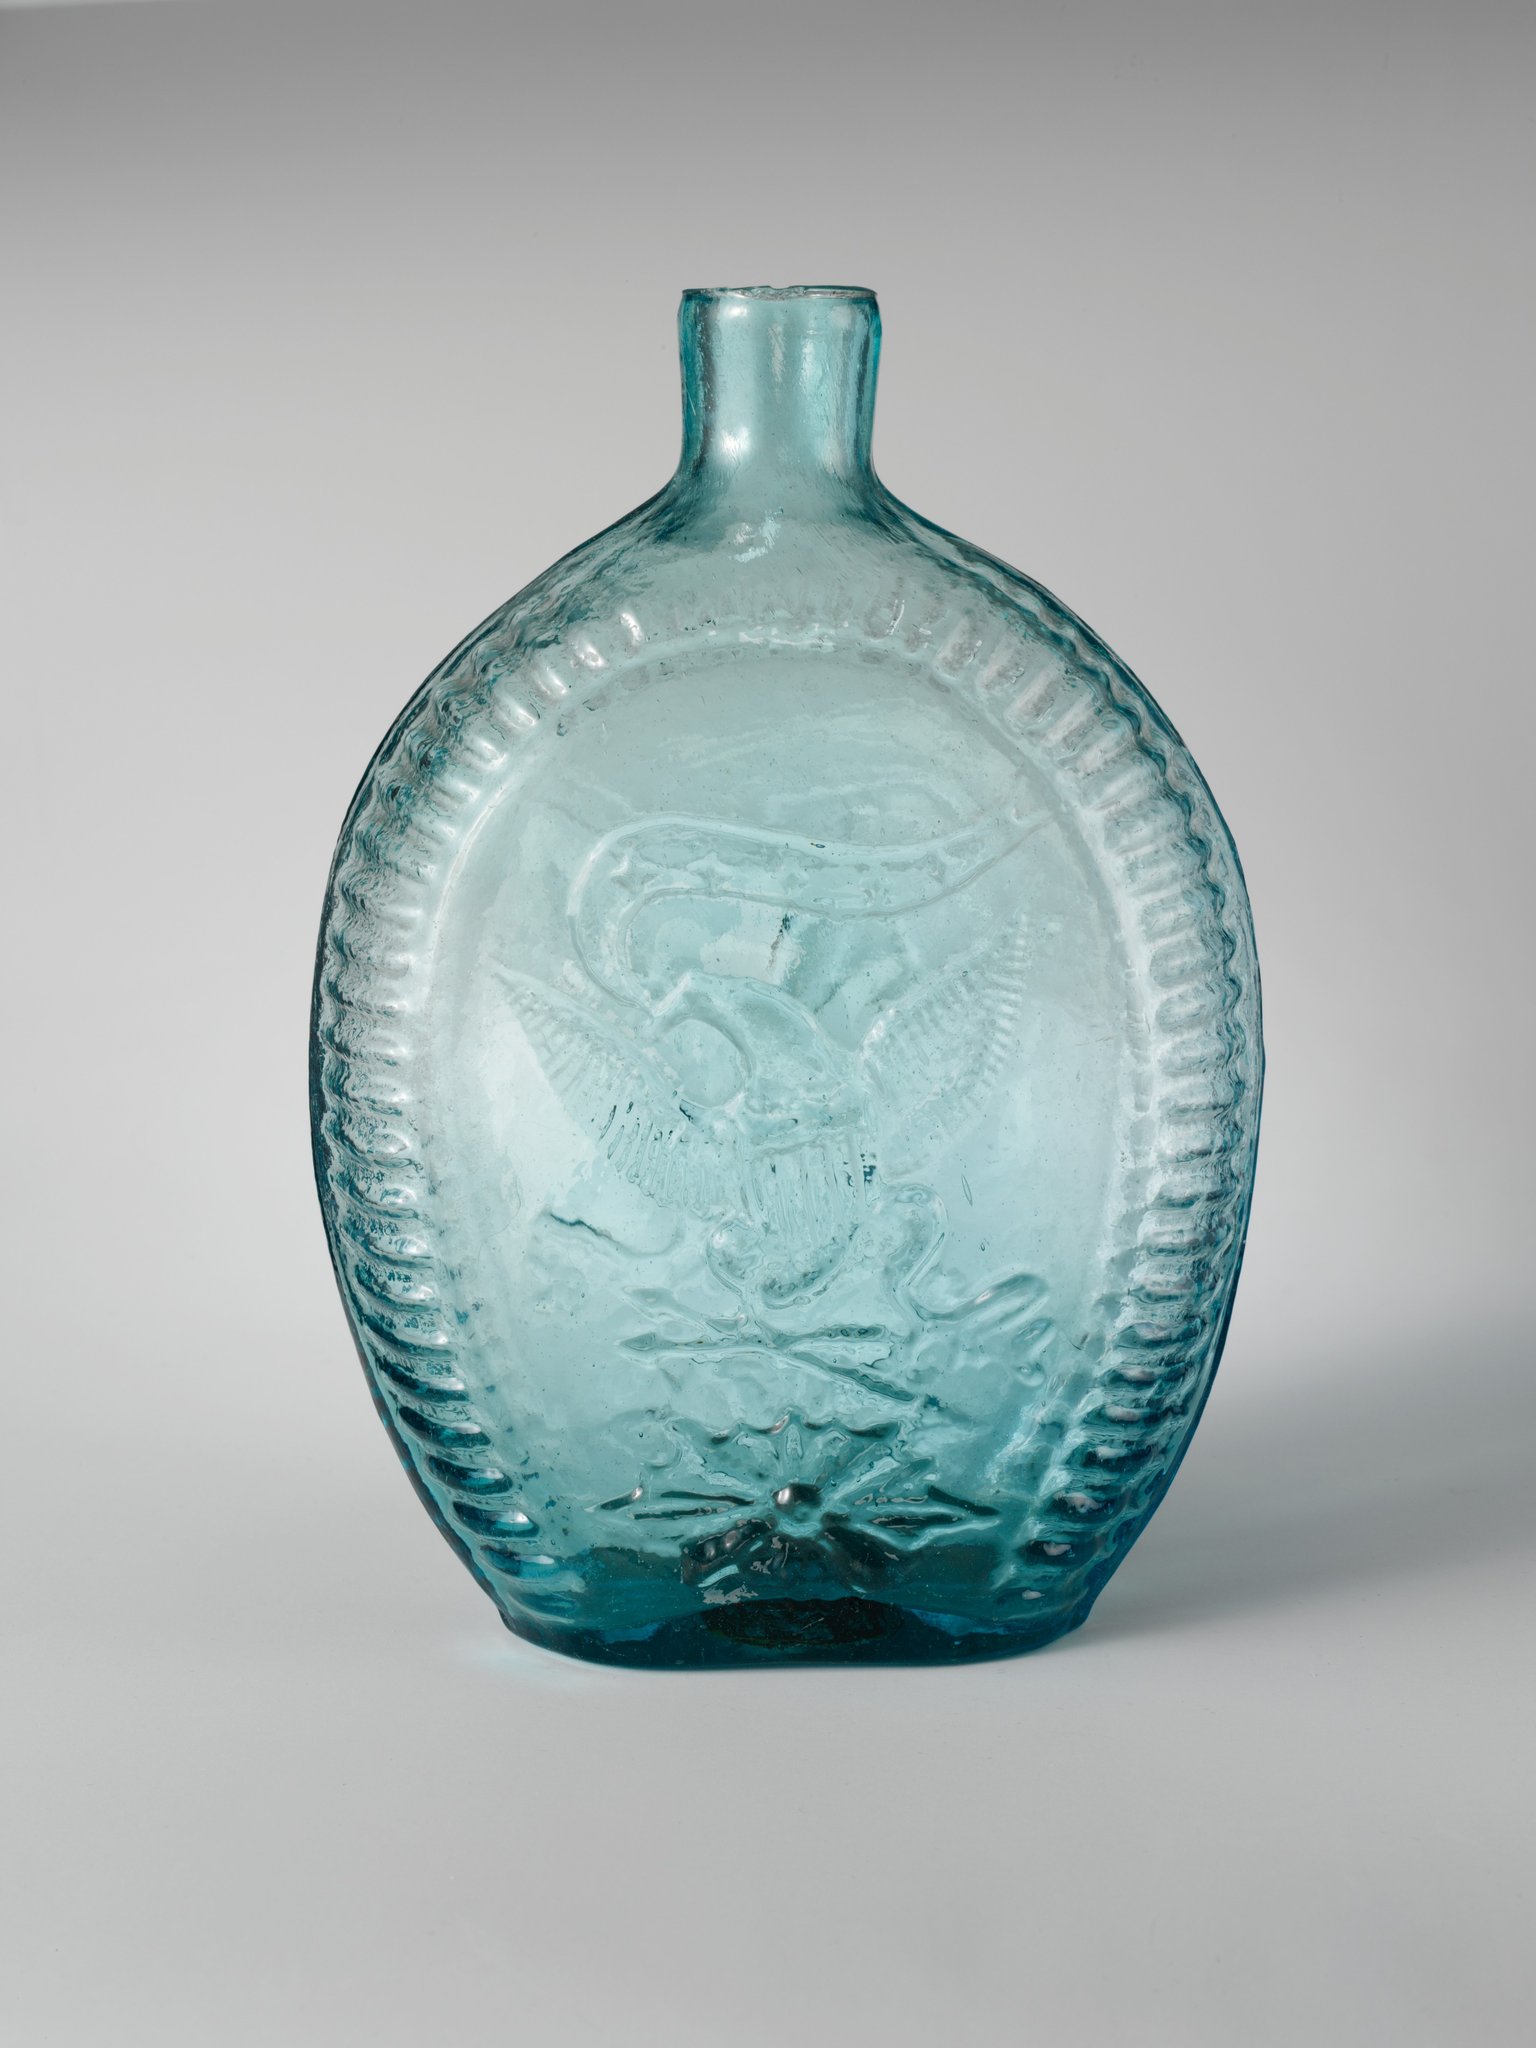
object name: flask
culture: american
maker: kentucky glass works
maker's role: maker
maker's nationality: american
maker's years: 1850-1855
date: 1840-1850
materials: gemstone, glass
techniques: glassblowing, molding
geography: united states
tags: eagles